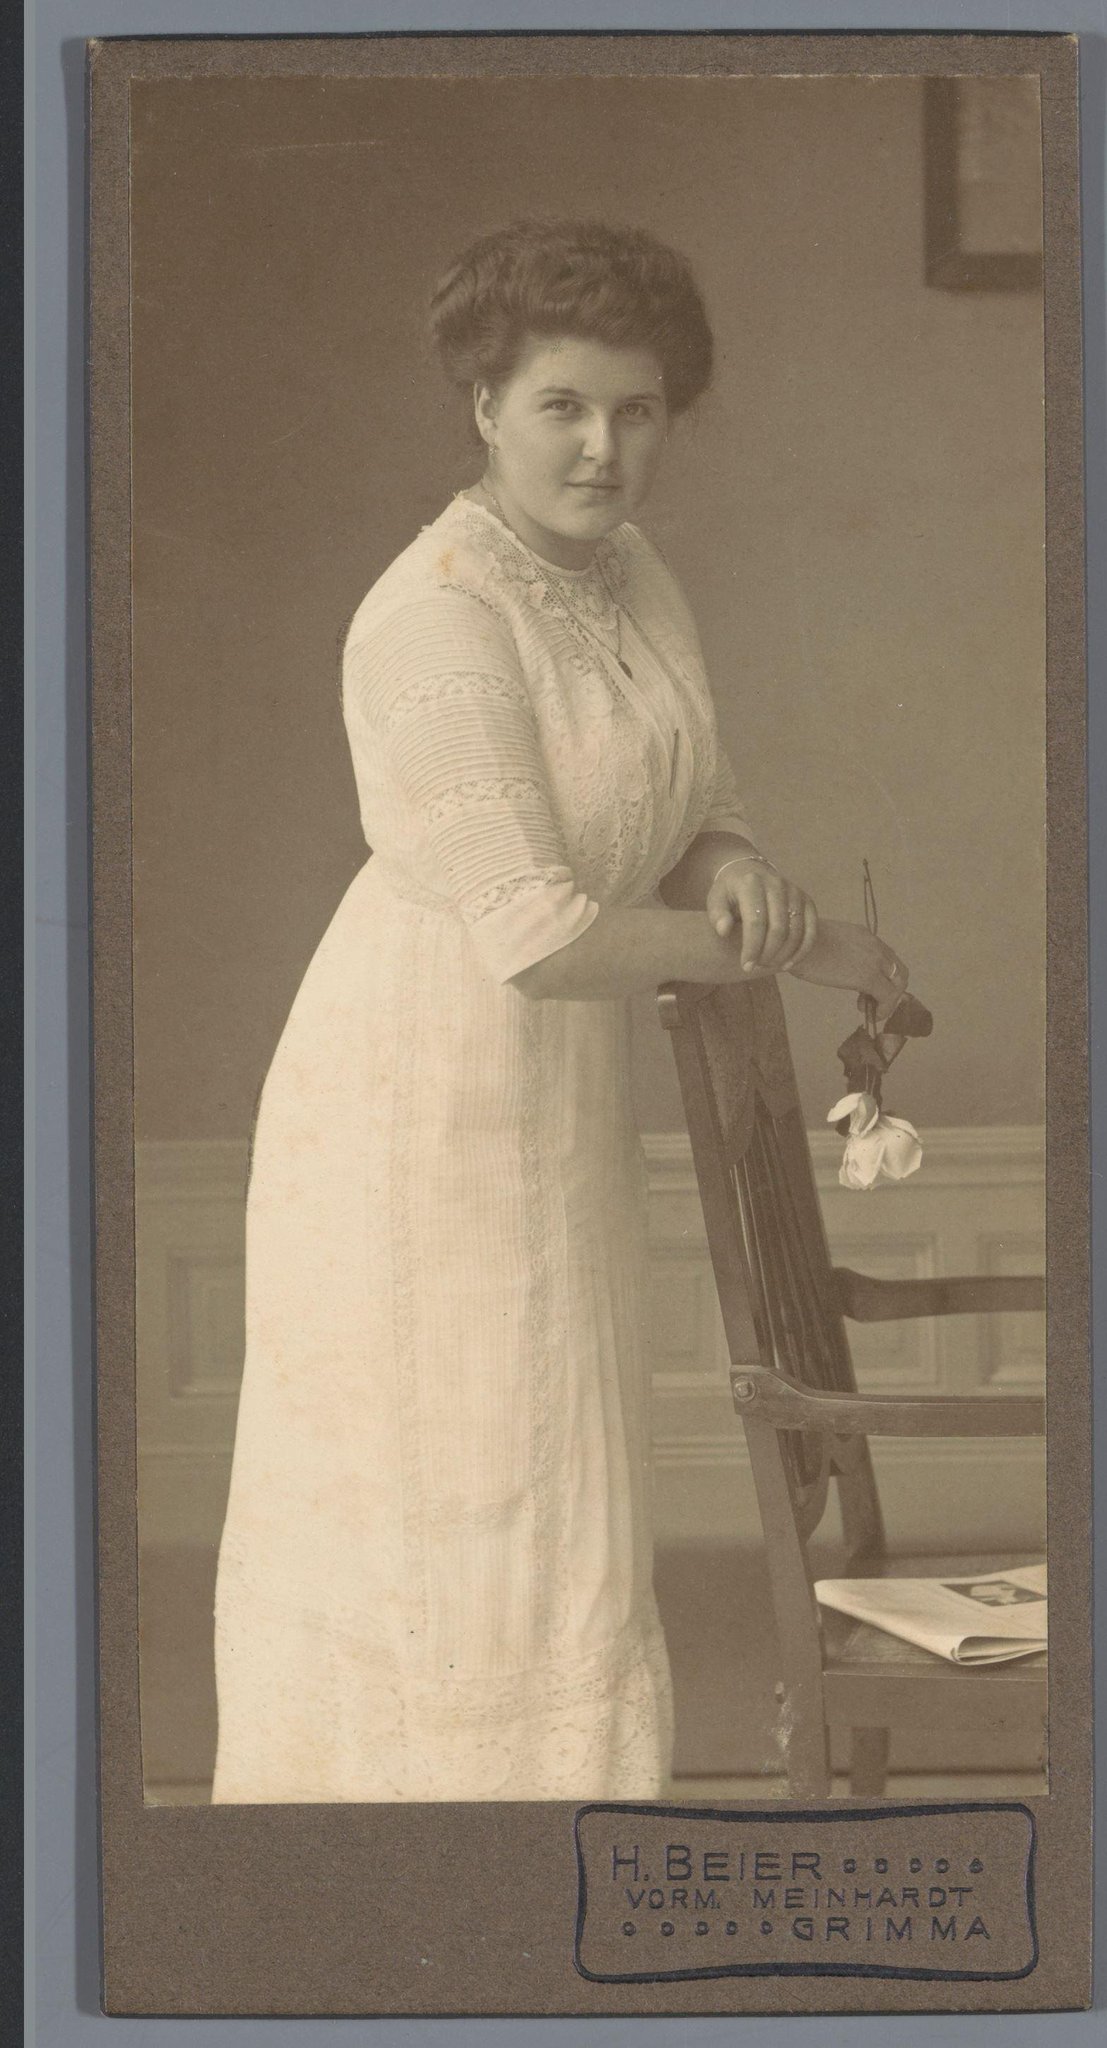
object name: carte de visite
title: Portret van een onbekende vrouw met een roos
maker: friedrich hermann beier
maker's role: fotograaf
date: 1913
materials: paper, cardboard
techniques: gelatin silver print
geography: grimma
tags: adult woman, anonymous historical person portrayed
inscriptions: inscription: ‘DIE PLATTE BLEIBT FÜR/ NACHBESTELLUNGEN/ U. VERGRÖSSERUNGEN/ AUFBEWAHRT.’, address: ‘GRIMMA/ LANGSTR. 28/ TELEFON 283’, inscription: ‘Souvenir affectueux/ d'une amie du/ cercle./ J. Faigaux./ Grimma le 2 Janvier 1913’